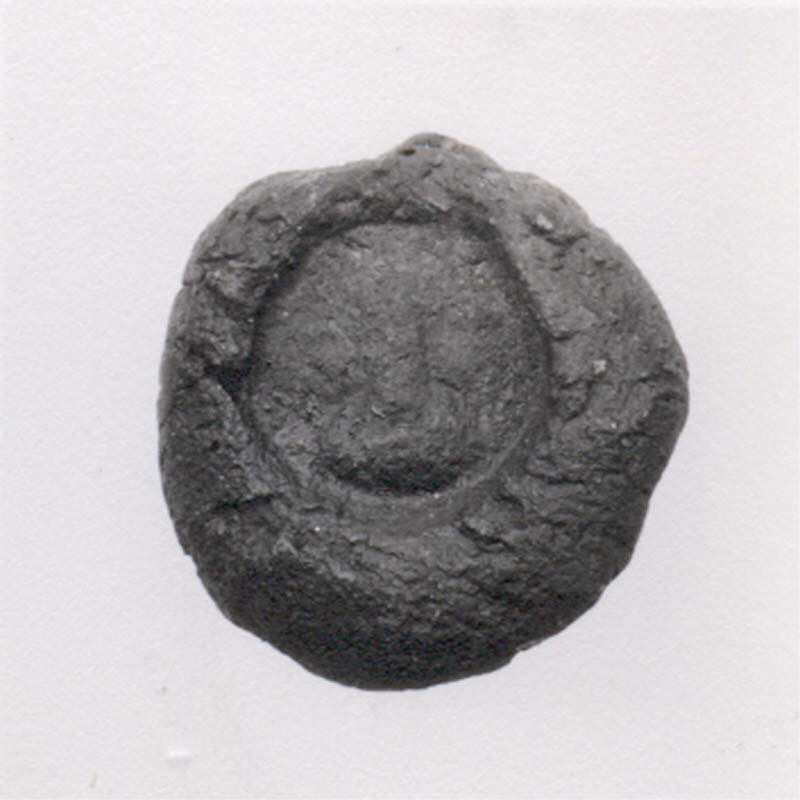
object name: sealing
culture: sasanian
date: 601-700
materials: clay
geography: iran